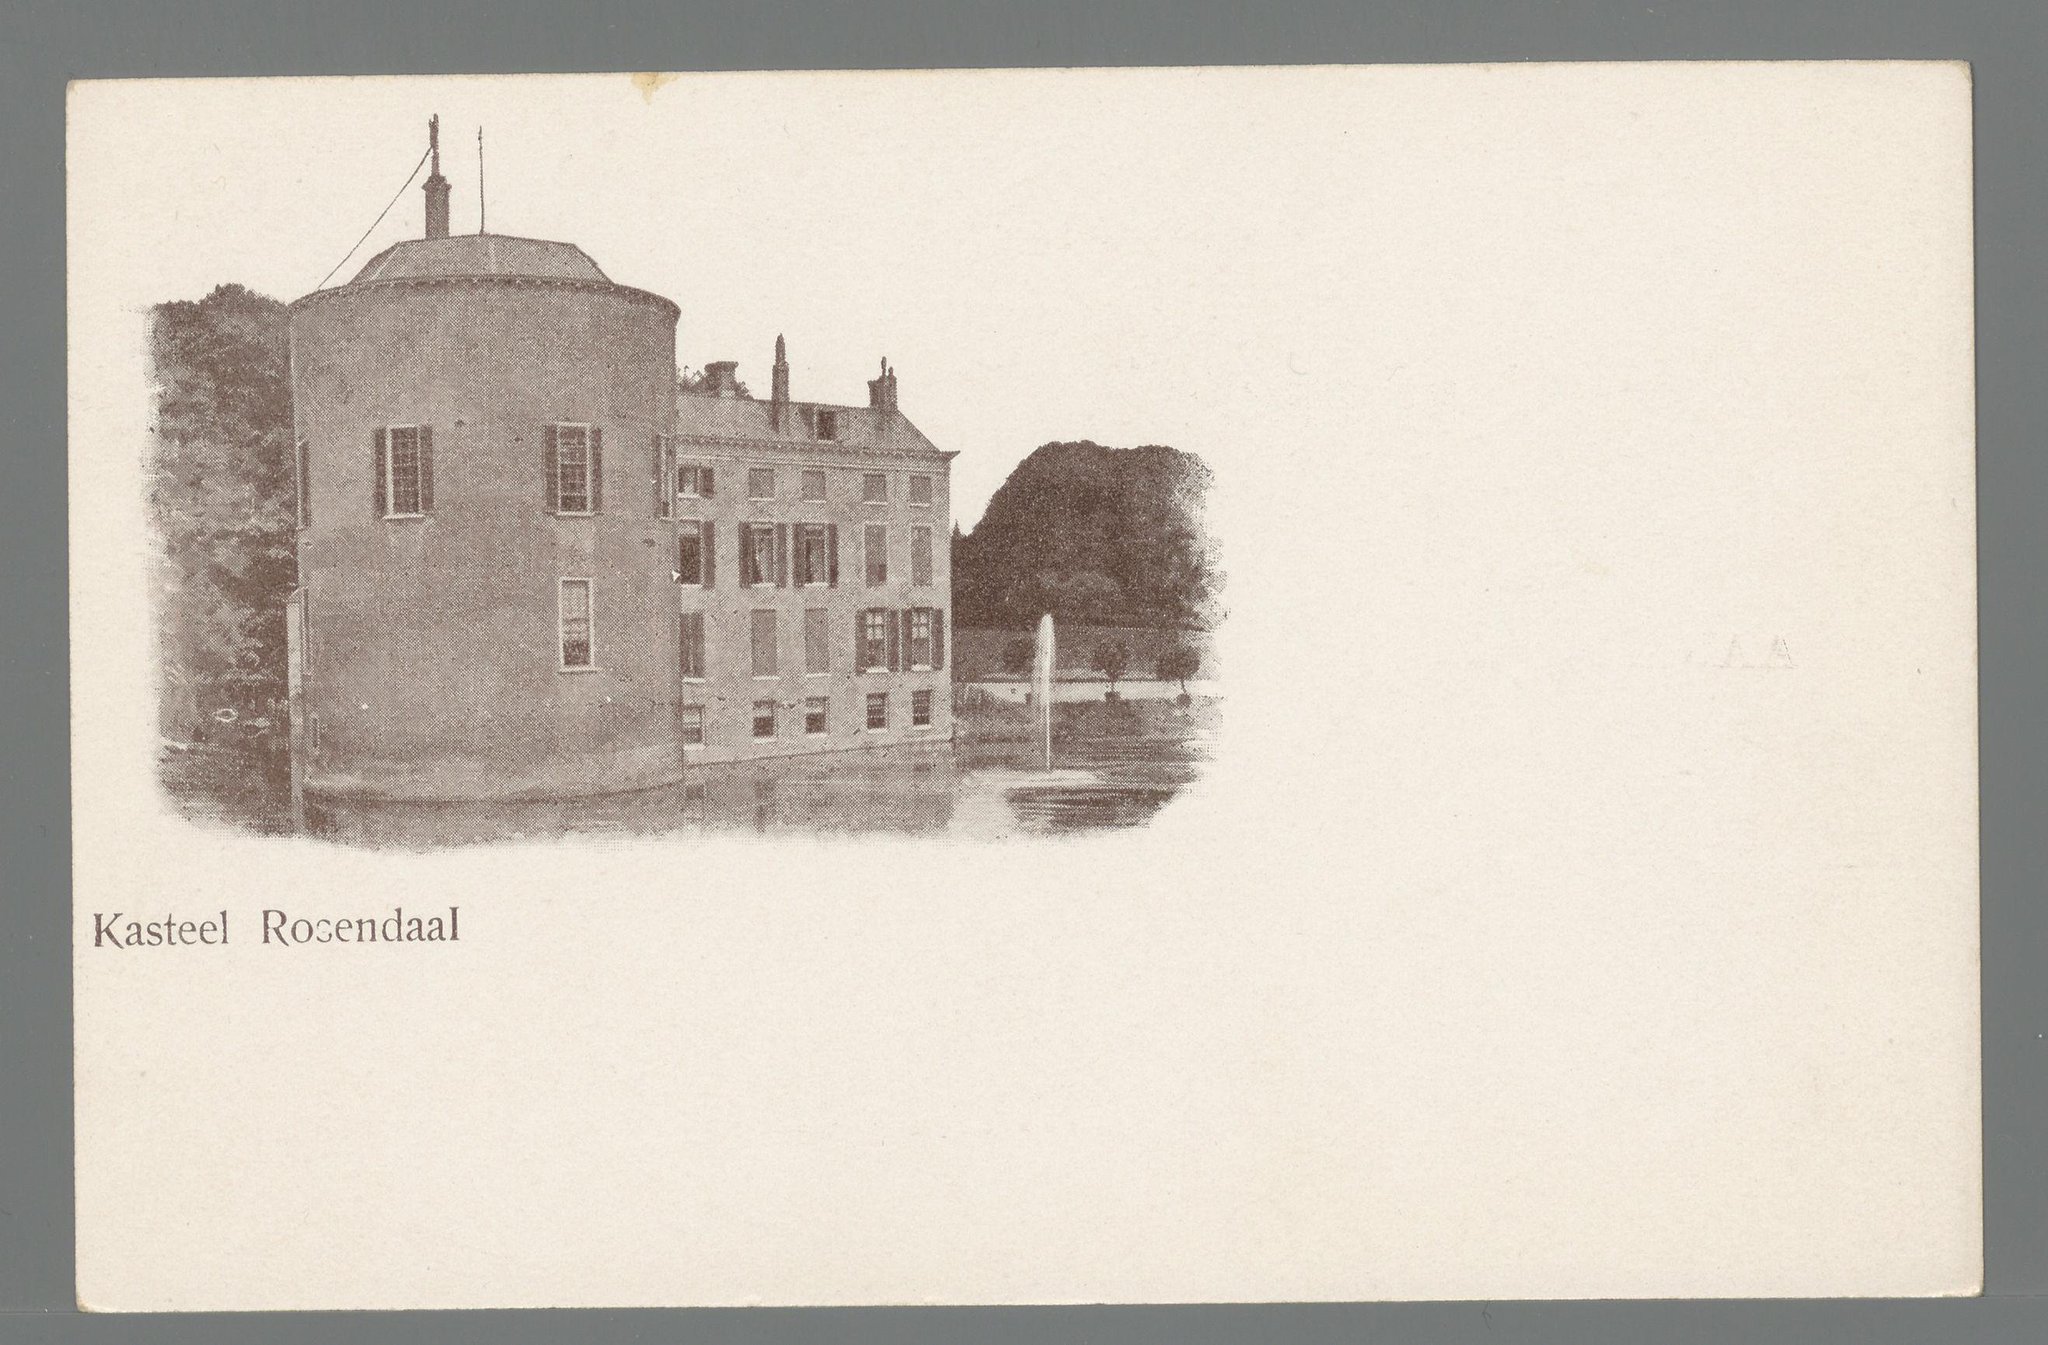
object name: photomechanical print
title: Kasteel Rosendaal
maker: Anonymous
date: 1895-1901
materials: cardboard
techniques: autotype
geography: rozendaal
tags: castle, pond